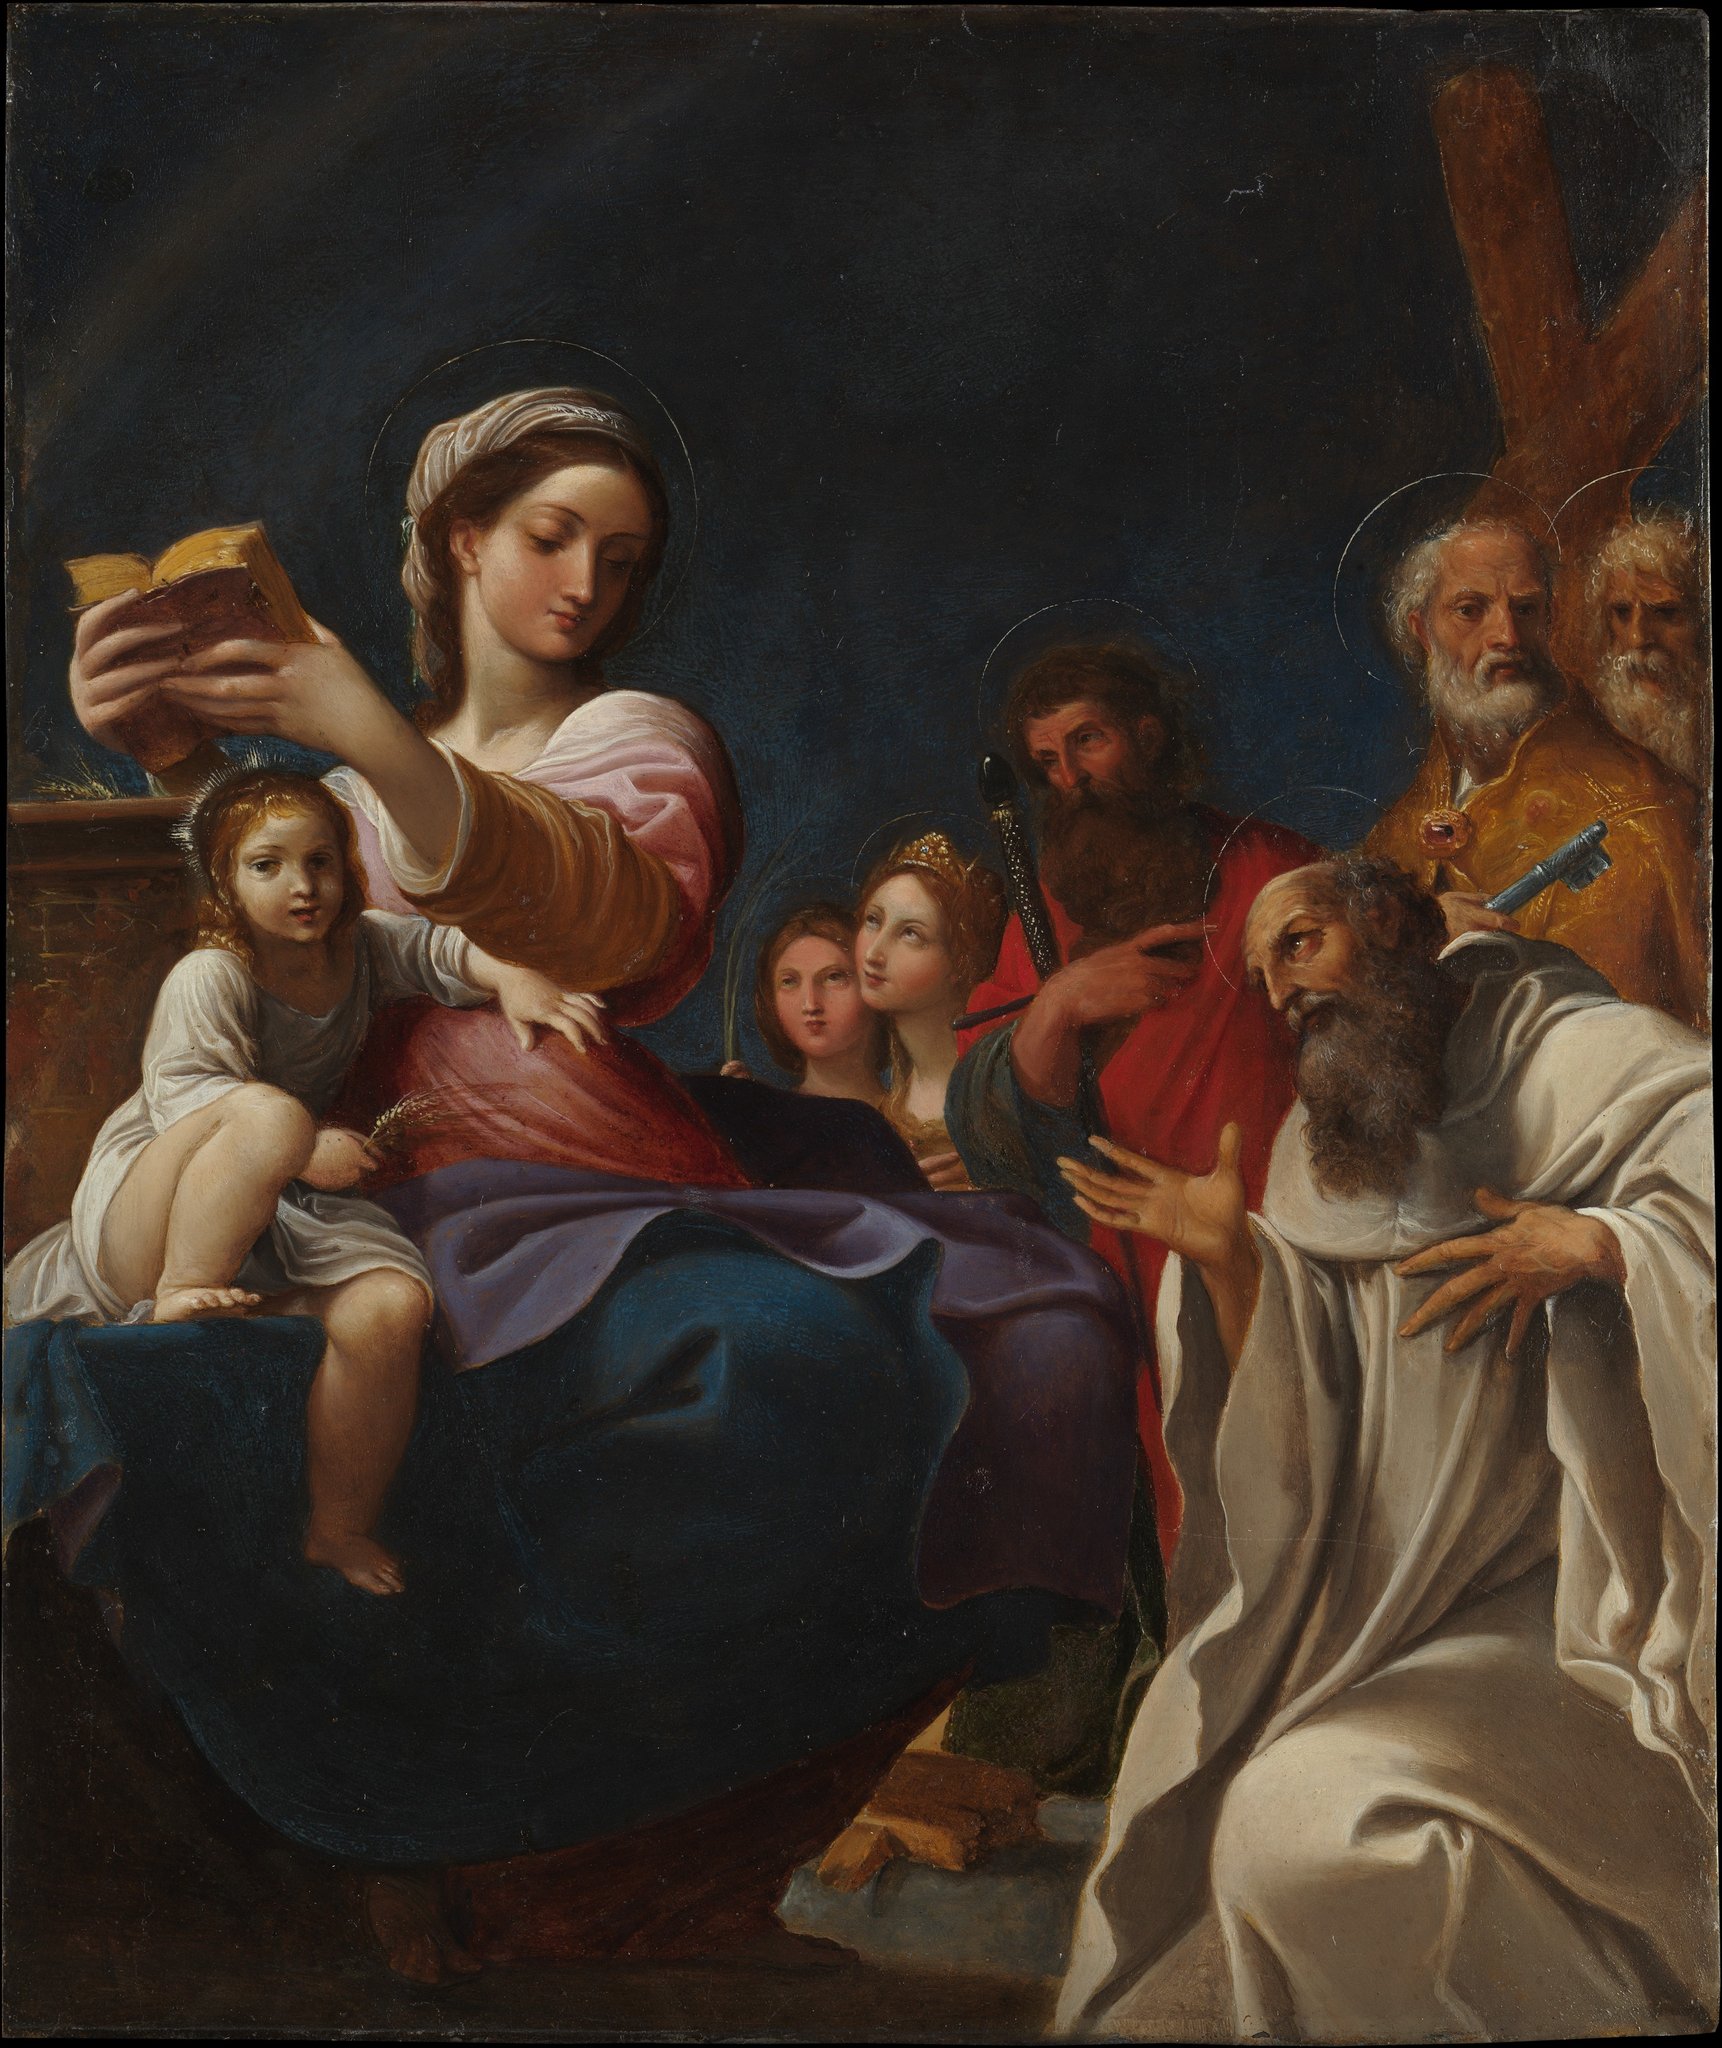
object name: painting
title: Madonna and Child with Saints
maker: ludovico carracci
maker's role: artist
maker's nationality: italian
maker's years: 1555-1619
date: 1607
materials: copper, oil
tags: madonna and child,saint catherine,saint peter,saints,saint andrew